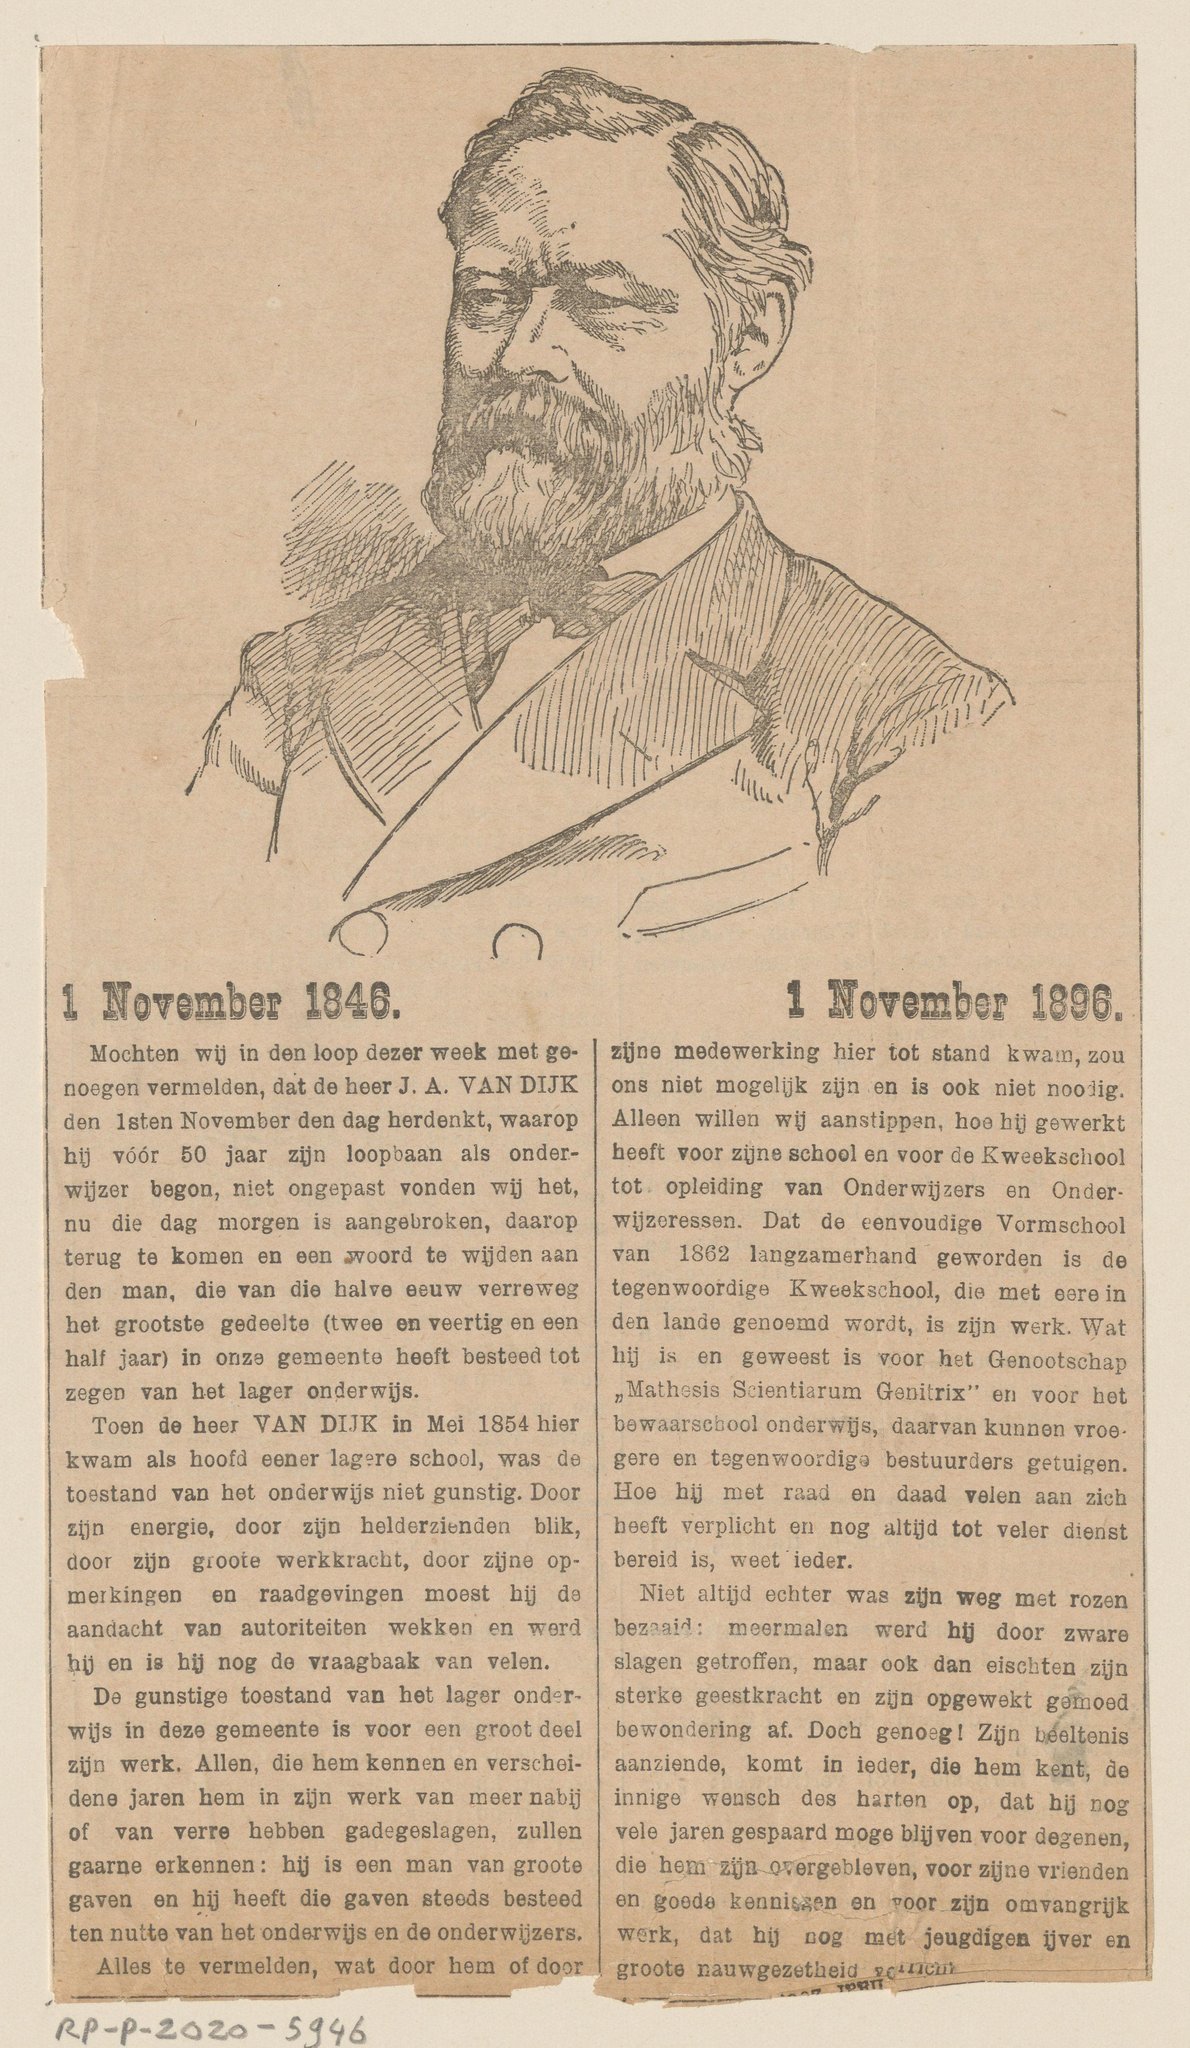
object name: photomechanical print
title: Portret van J.A. van Dijk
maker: Anonymous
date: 1896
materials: paper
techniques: line block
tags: historical persons, teacher and pupil